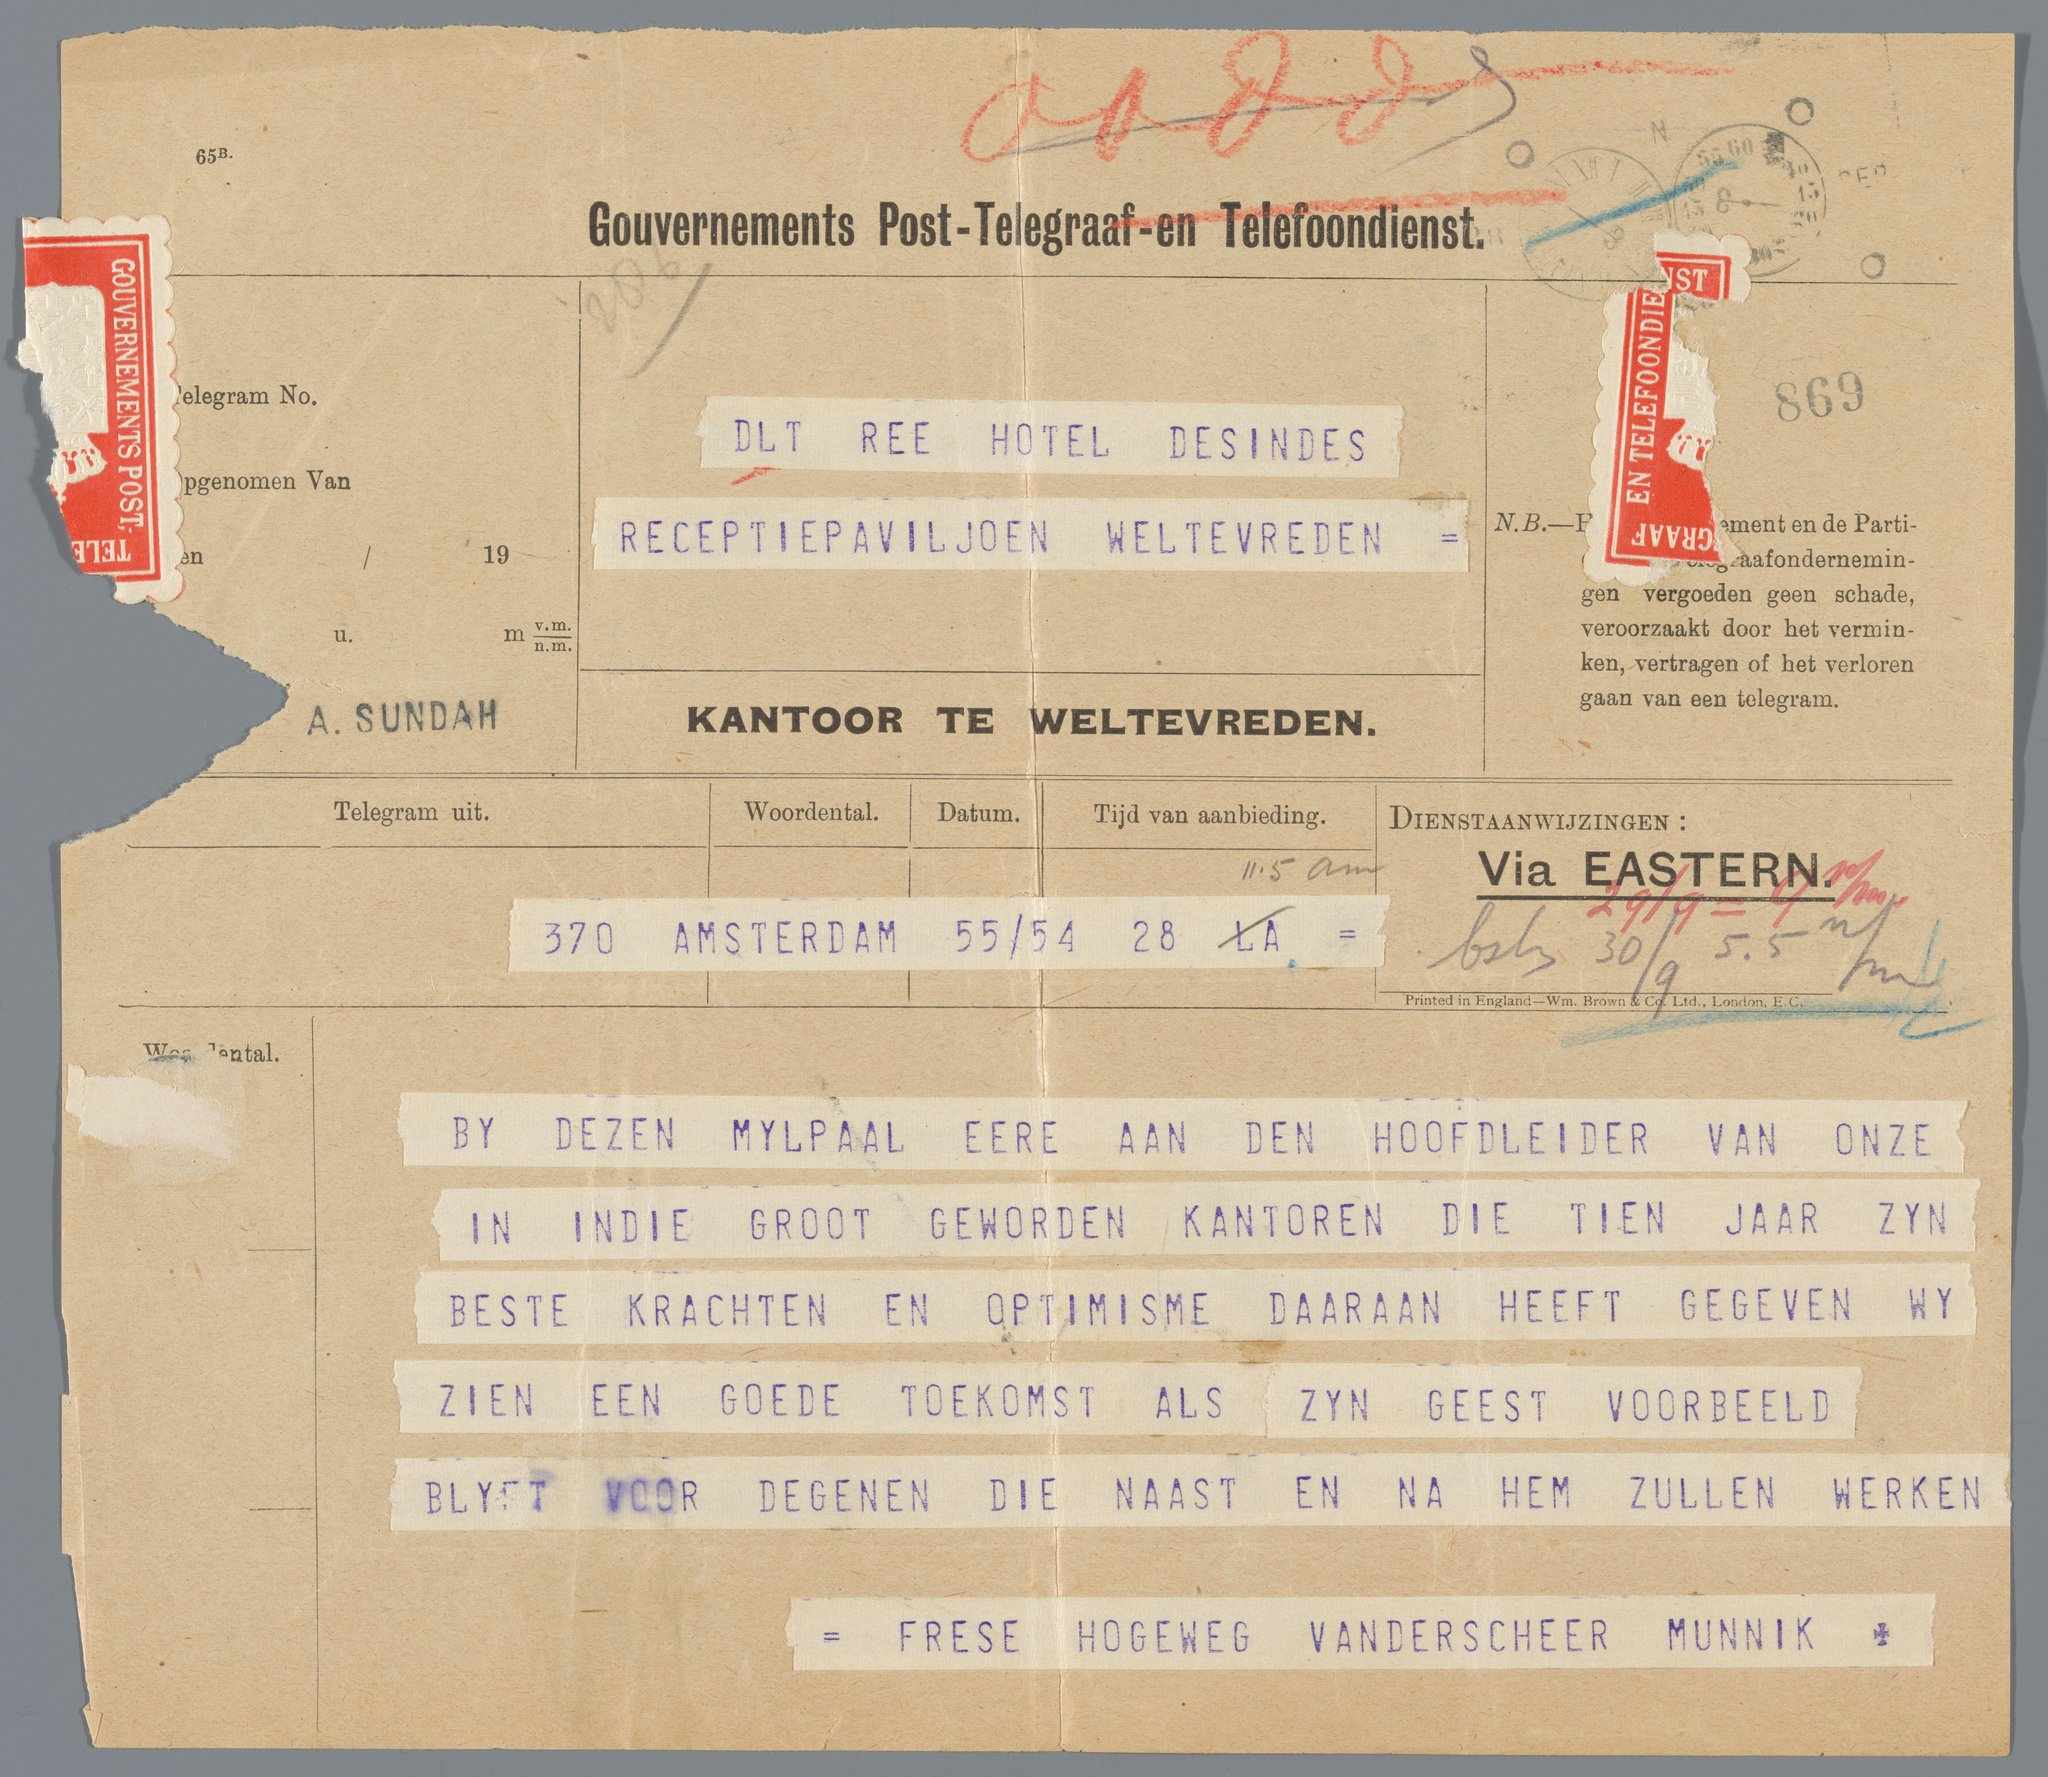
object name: telegram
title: Telegram met gelukwensen, 1928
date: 1928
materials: paper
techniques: typewriting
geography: weltevreden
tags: batavia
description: Telegram met gelukwensen namens Frese Hogeweg Vanderscheer Munnik, verzonden vanuit Amsterdam op 29 september 1928. Document van Gouvernements Post-, Telegraaf- en Telefoondienst, kantoor Weltevreden, met gedrukte en getypte tekst, stempels en een verbroken zegel. Behoort bij het herinneringsalbum aangeboden aan Willem Ree van accountantsbureau Frese & Hogeweg bij zijn vertrek bij het kantoor in Weltevreden op 30 september 1928.